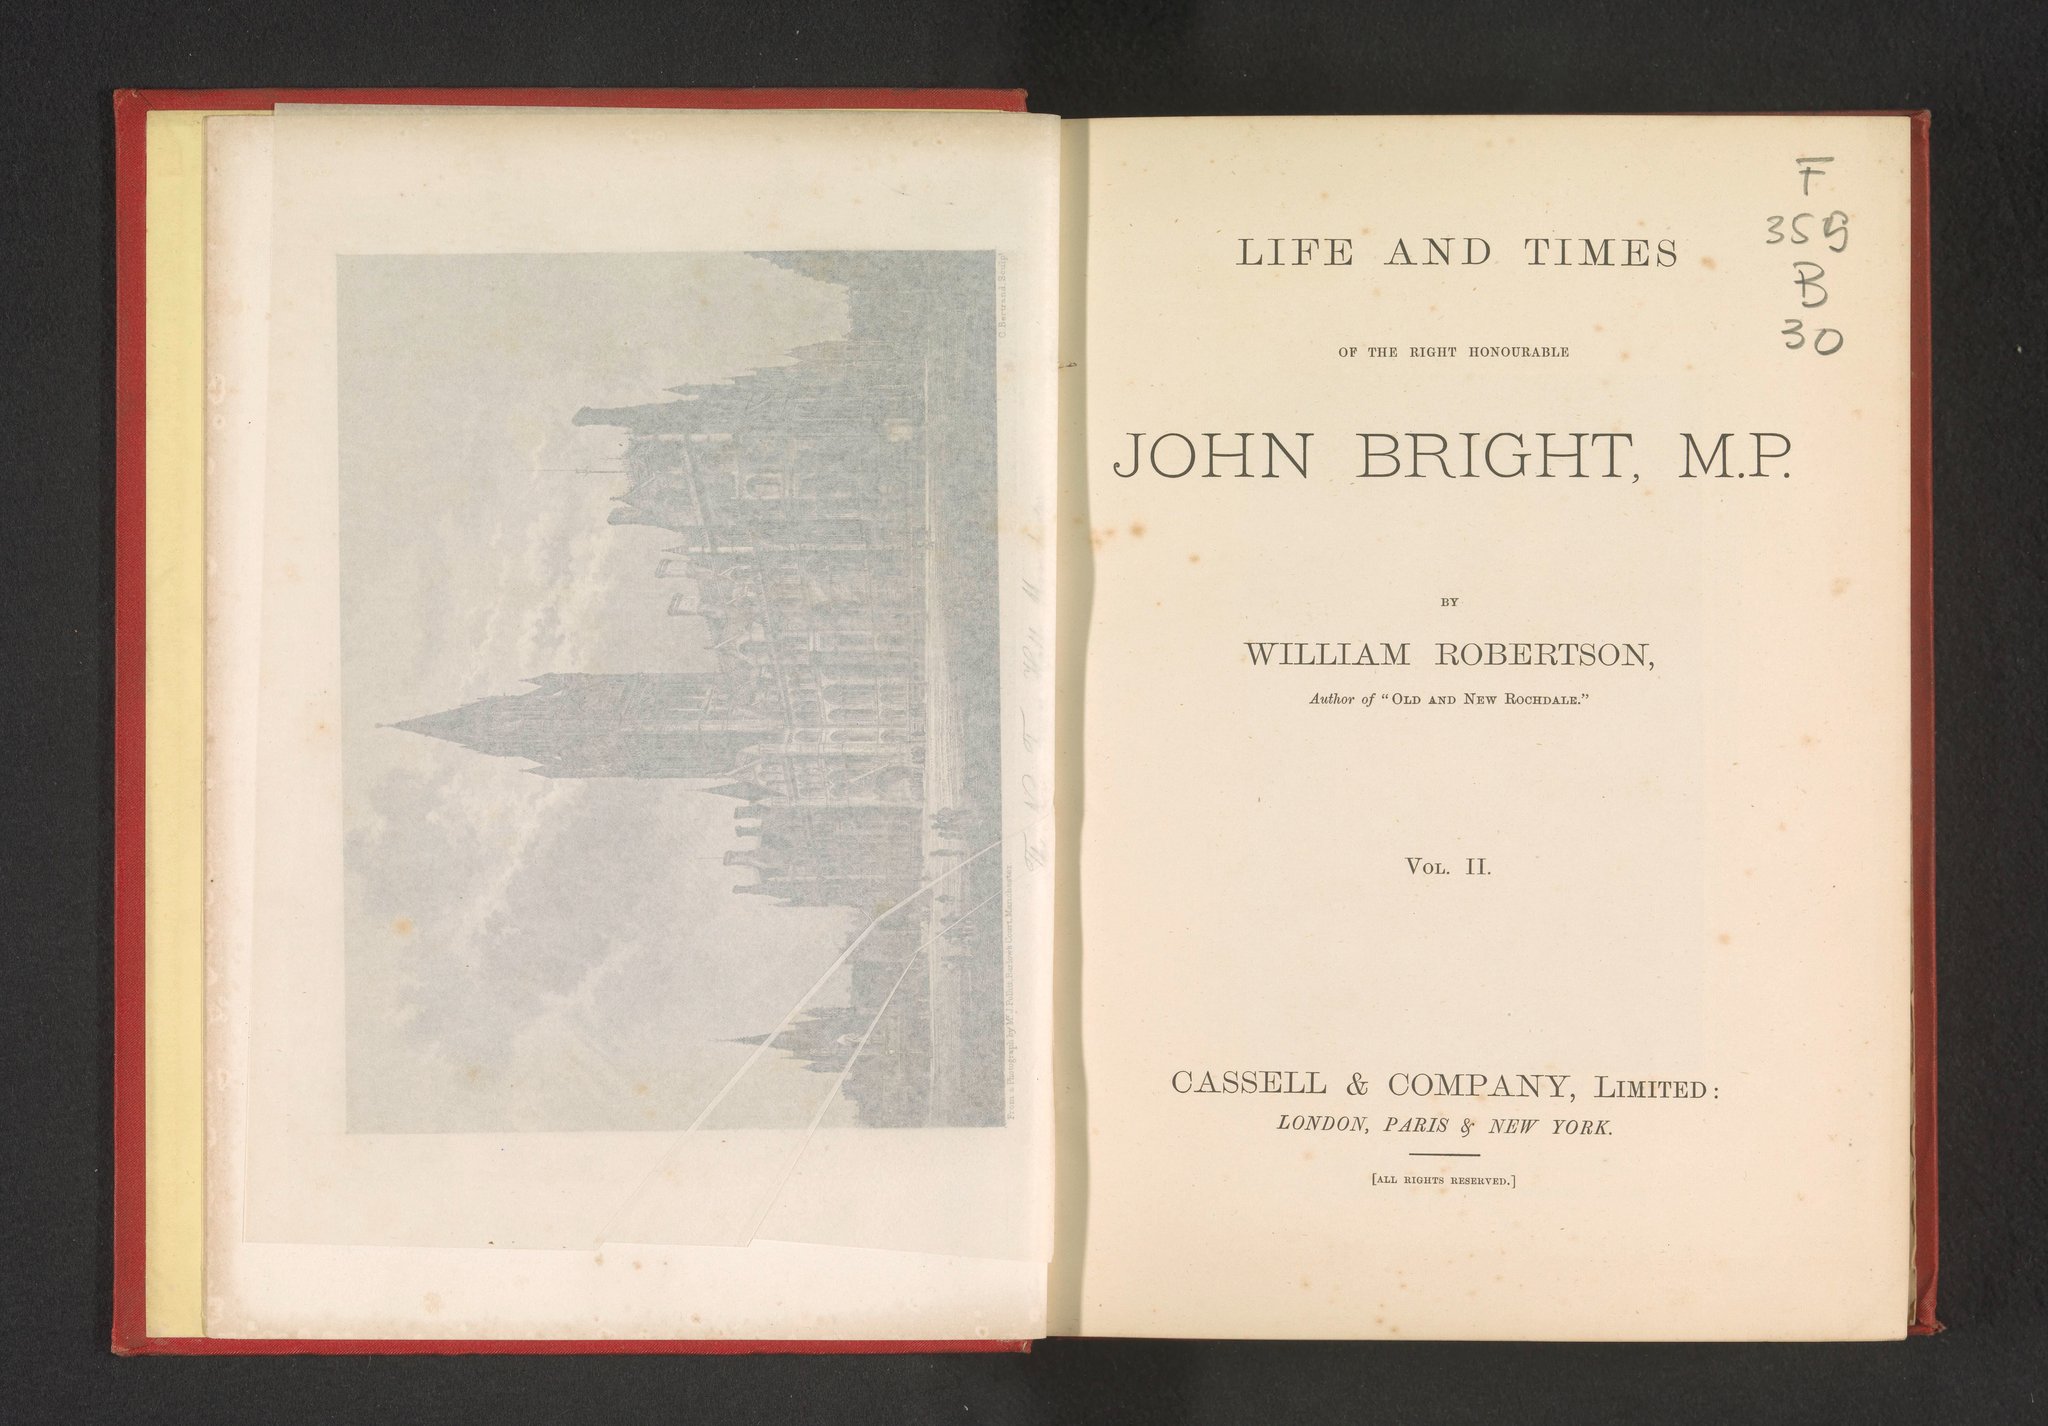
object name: book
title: Life and times of the right honourable John Bright, MP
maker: william robertson (auteur)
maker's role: auteur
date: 1884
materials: linen, paper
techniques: printing, woodburytype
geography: london